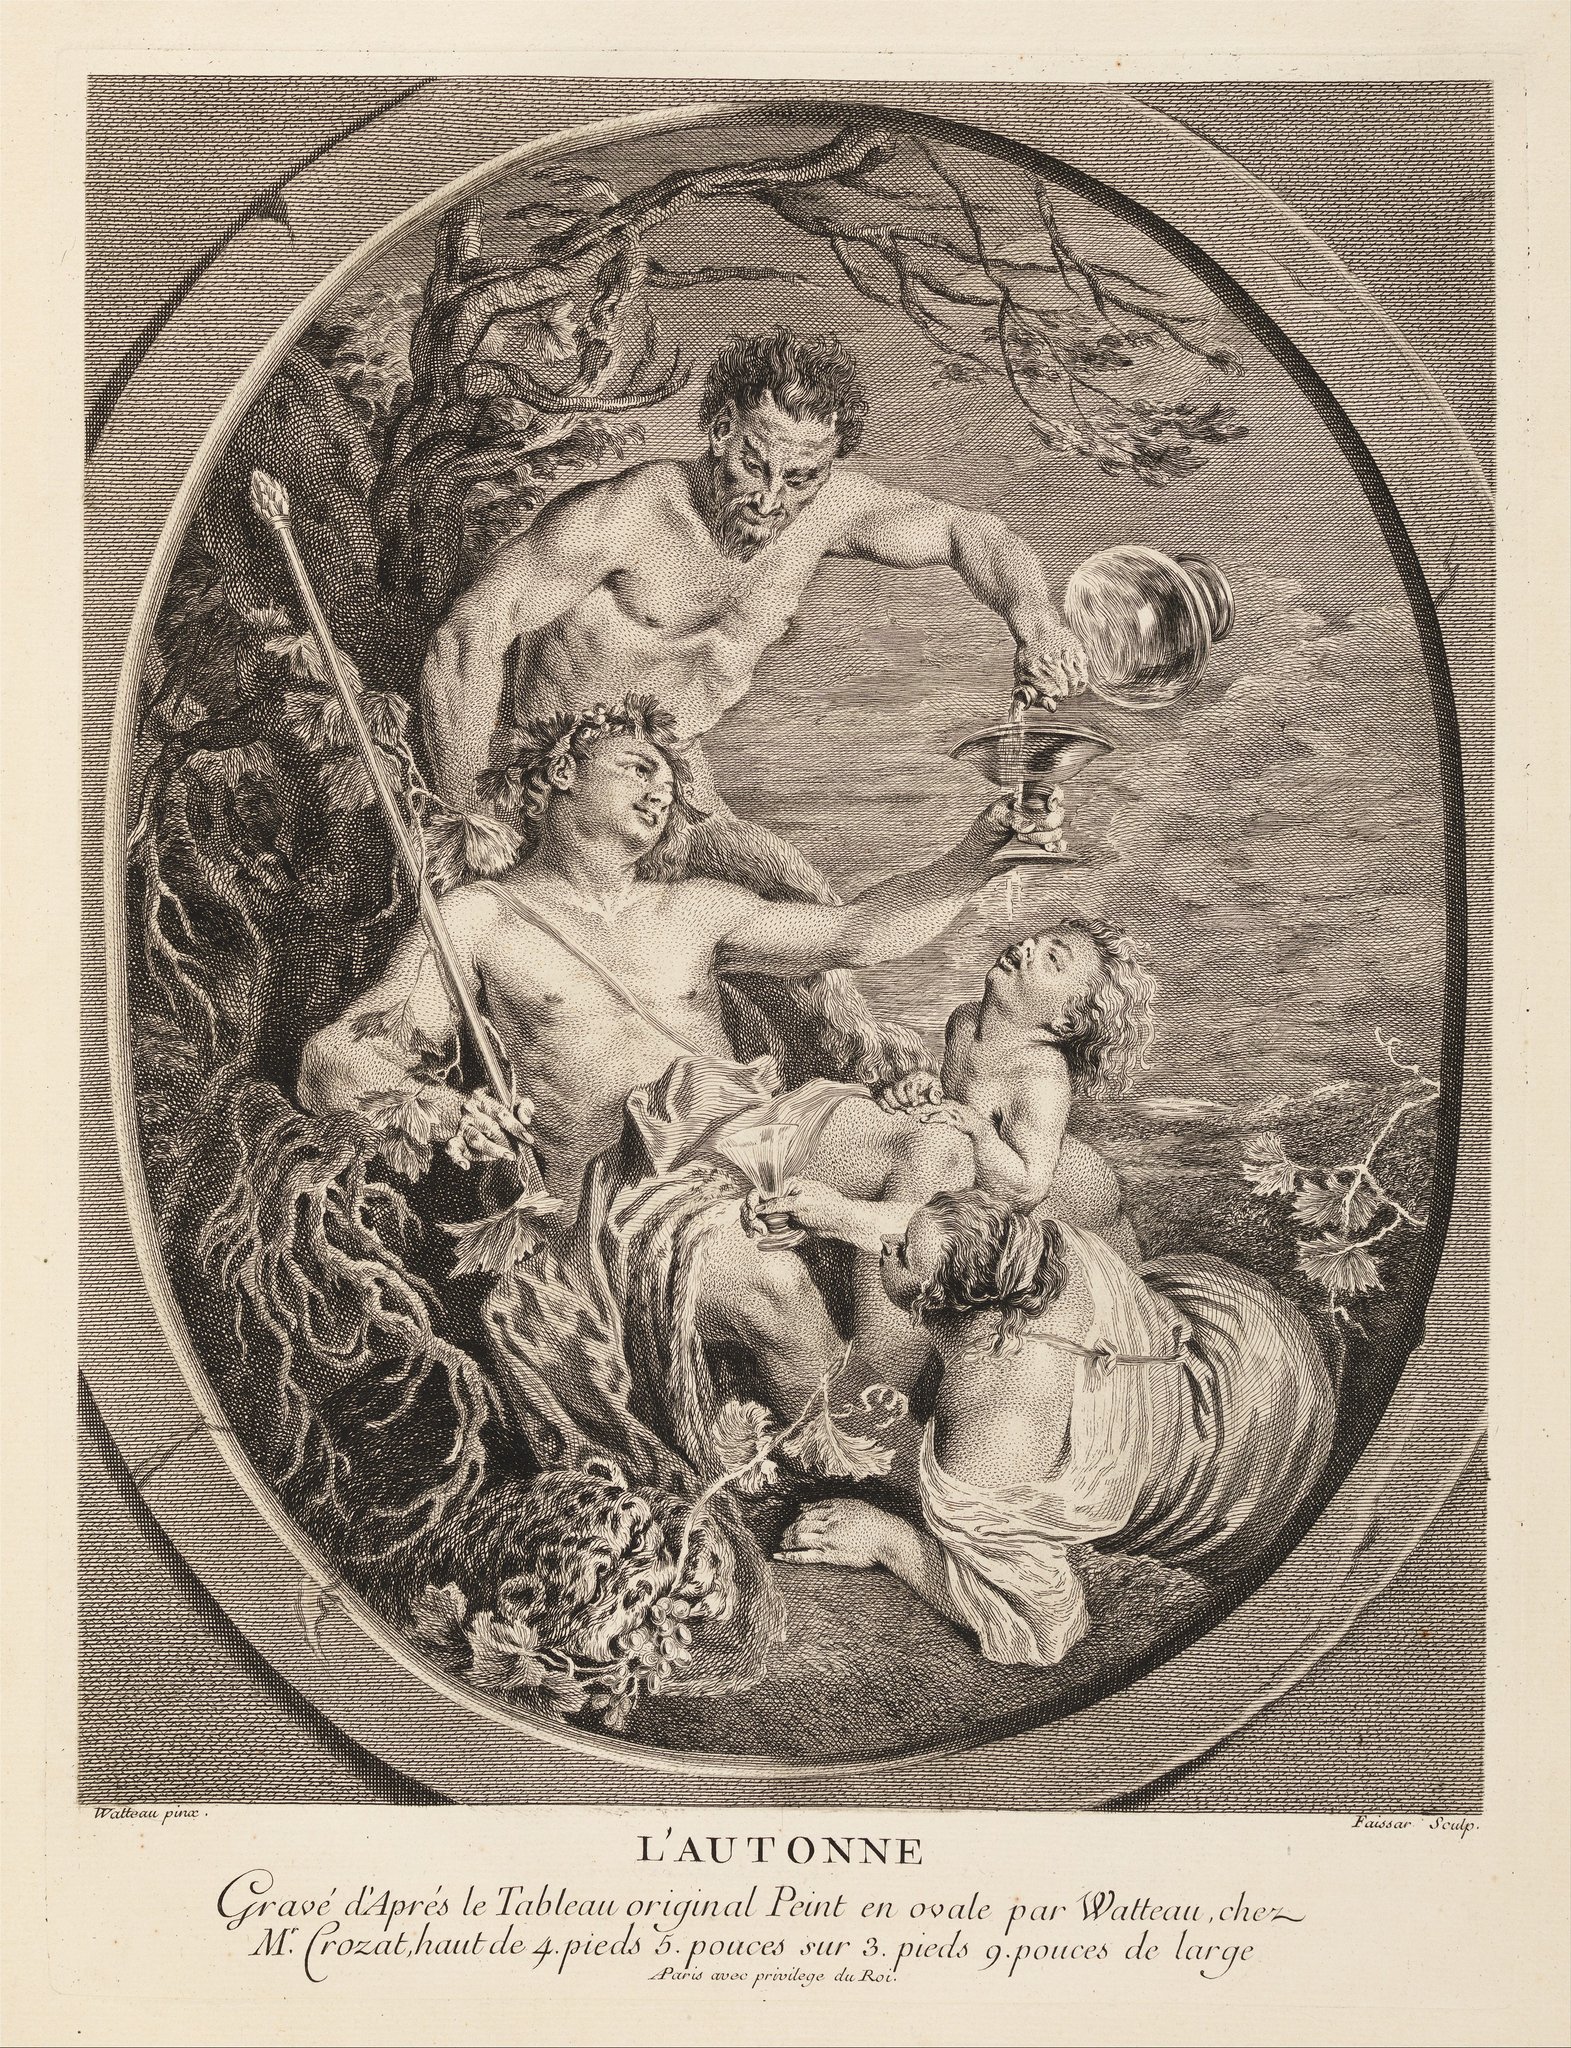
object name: book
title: L'Autonne, in L'Oeuvre D'Antoine Watteau Pientre du Roy en son Academie Roïale de Peinture et Sculpture Gravé d'après ses Tableaux & Desseins originaux...par les Soins de M. de Jullienne, Volume II, page 52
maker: etienne fessard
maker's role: artist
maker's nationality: french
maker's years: 1714-1777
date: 1740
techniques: engraving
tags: men,women,satyrs,autumn,drinking